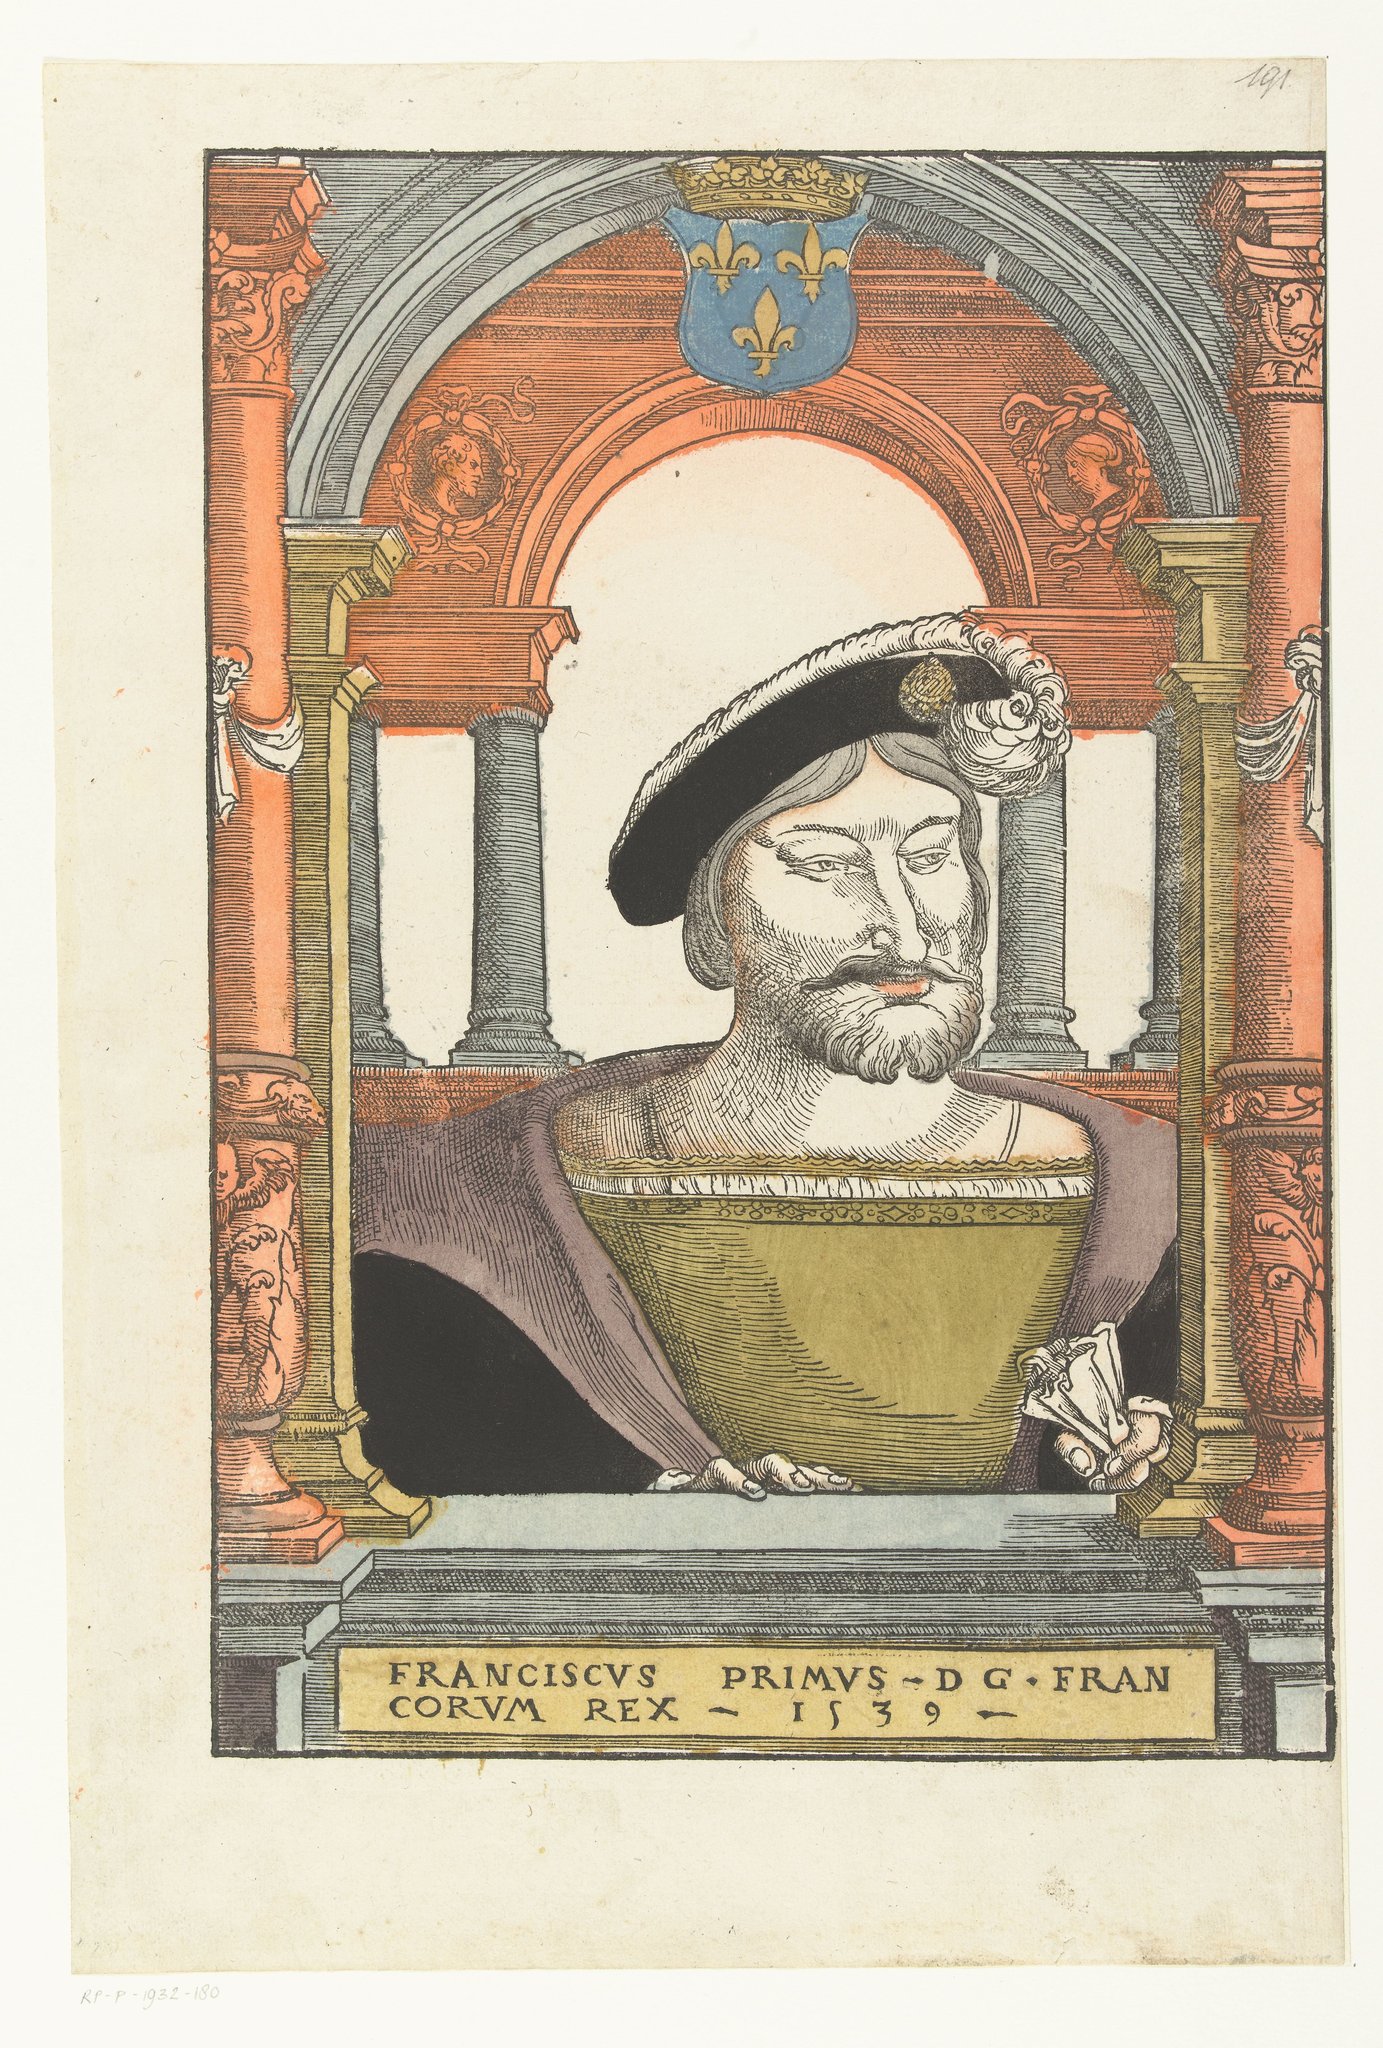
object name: print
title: Portret van Frans I van Frankrijk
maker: hans liefrinck (i)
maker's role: print maker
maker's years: 1518-1573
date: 1539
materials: paper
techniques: hand coloring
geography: antwerp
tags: frans i van valois-angoulême (koning van frankrijk)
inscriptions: date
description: Frans I, koning van Frankrijk, borststuk achter vensterbank, binnen twee rondbogen achter elkaar. In het midden bovenaan het gekroonde Franse wapen, onder de borstwering in gesneden letters de titel en jaartal. Pendant van portret van Eleonora van Frankrijk.